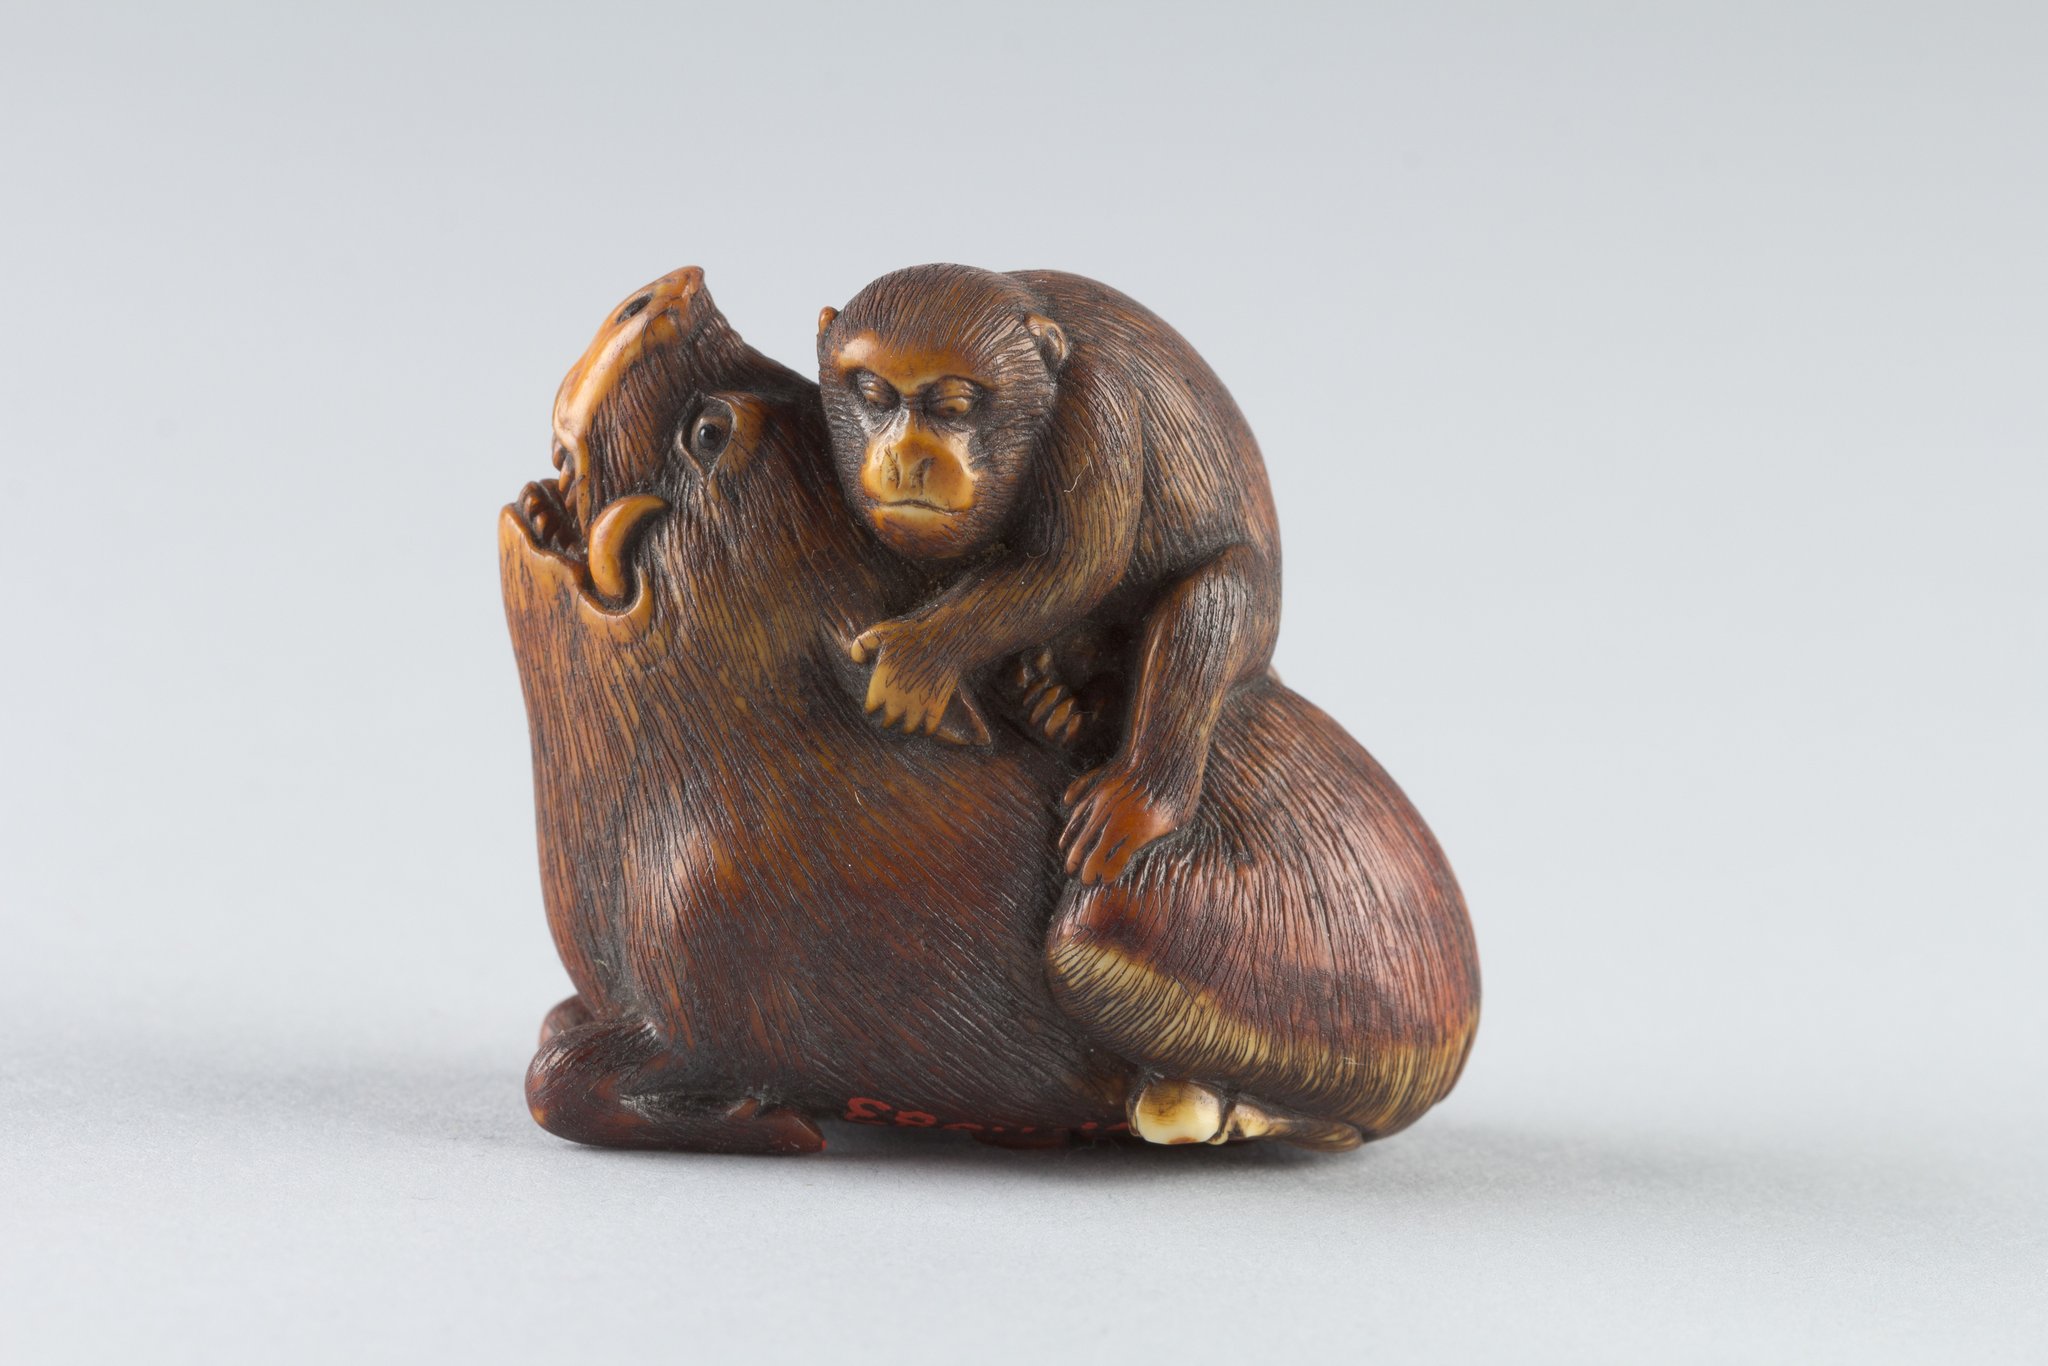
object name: netsuke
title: Netsuke of Monkey Attacking a Boar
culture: japanese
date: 1801-1900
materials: ivory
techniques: stain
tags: boars,monkeys